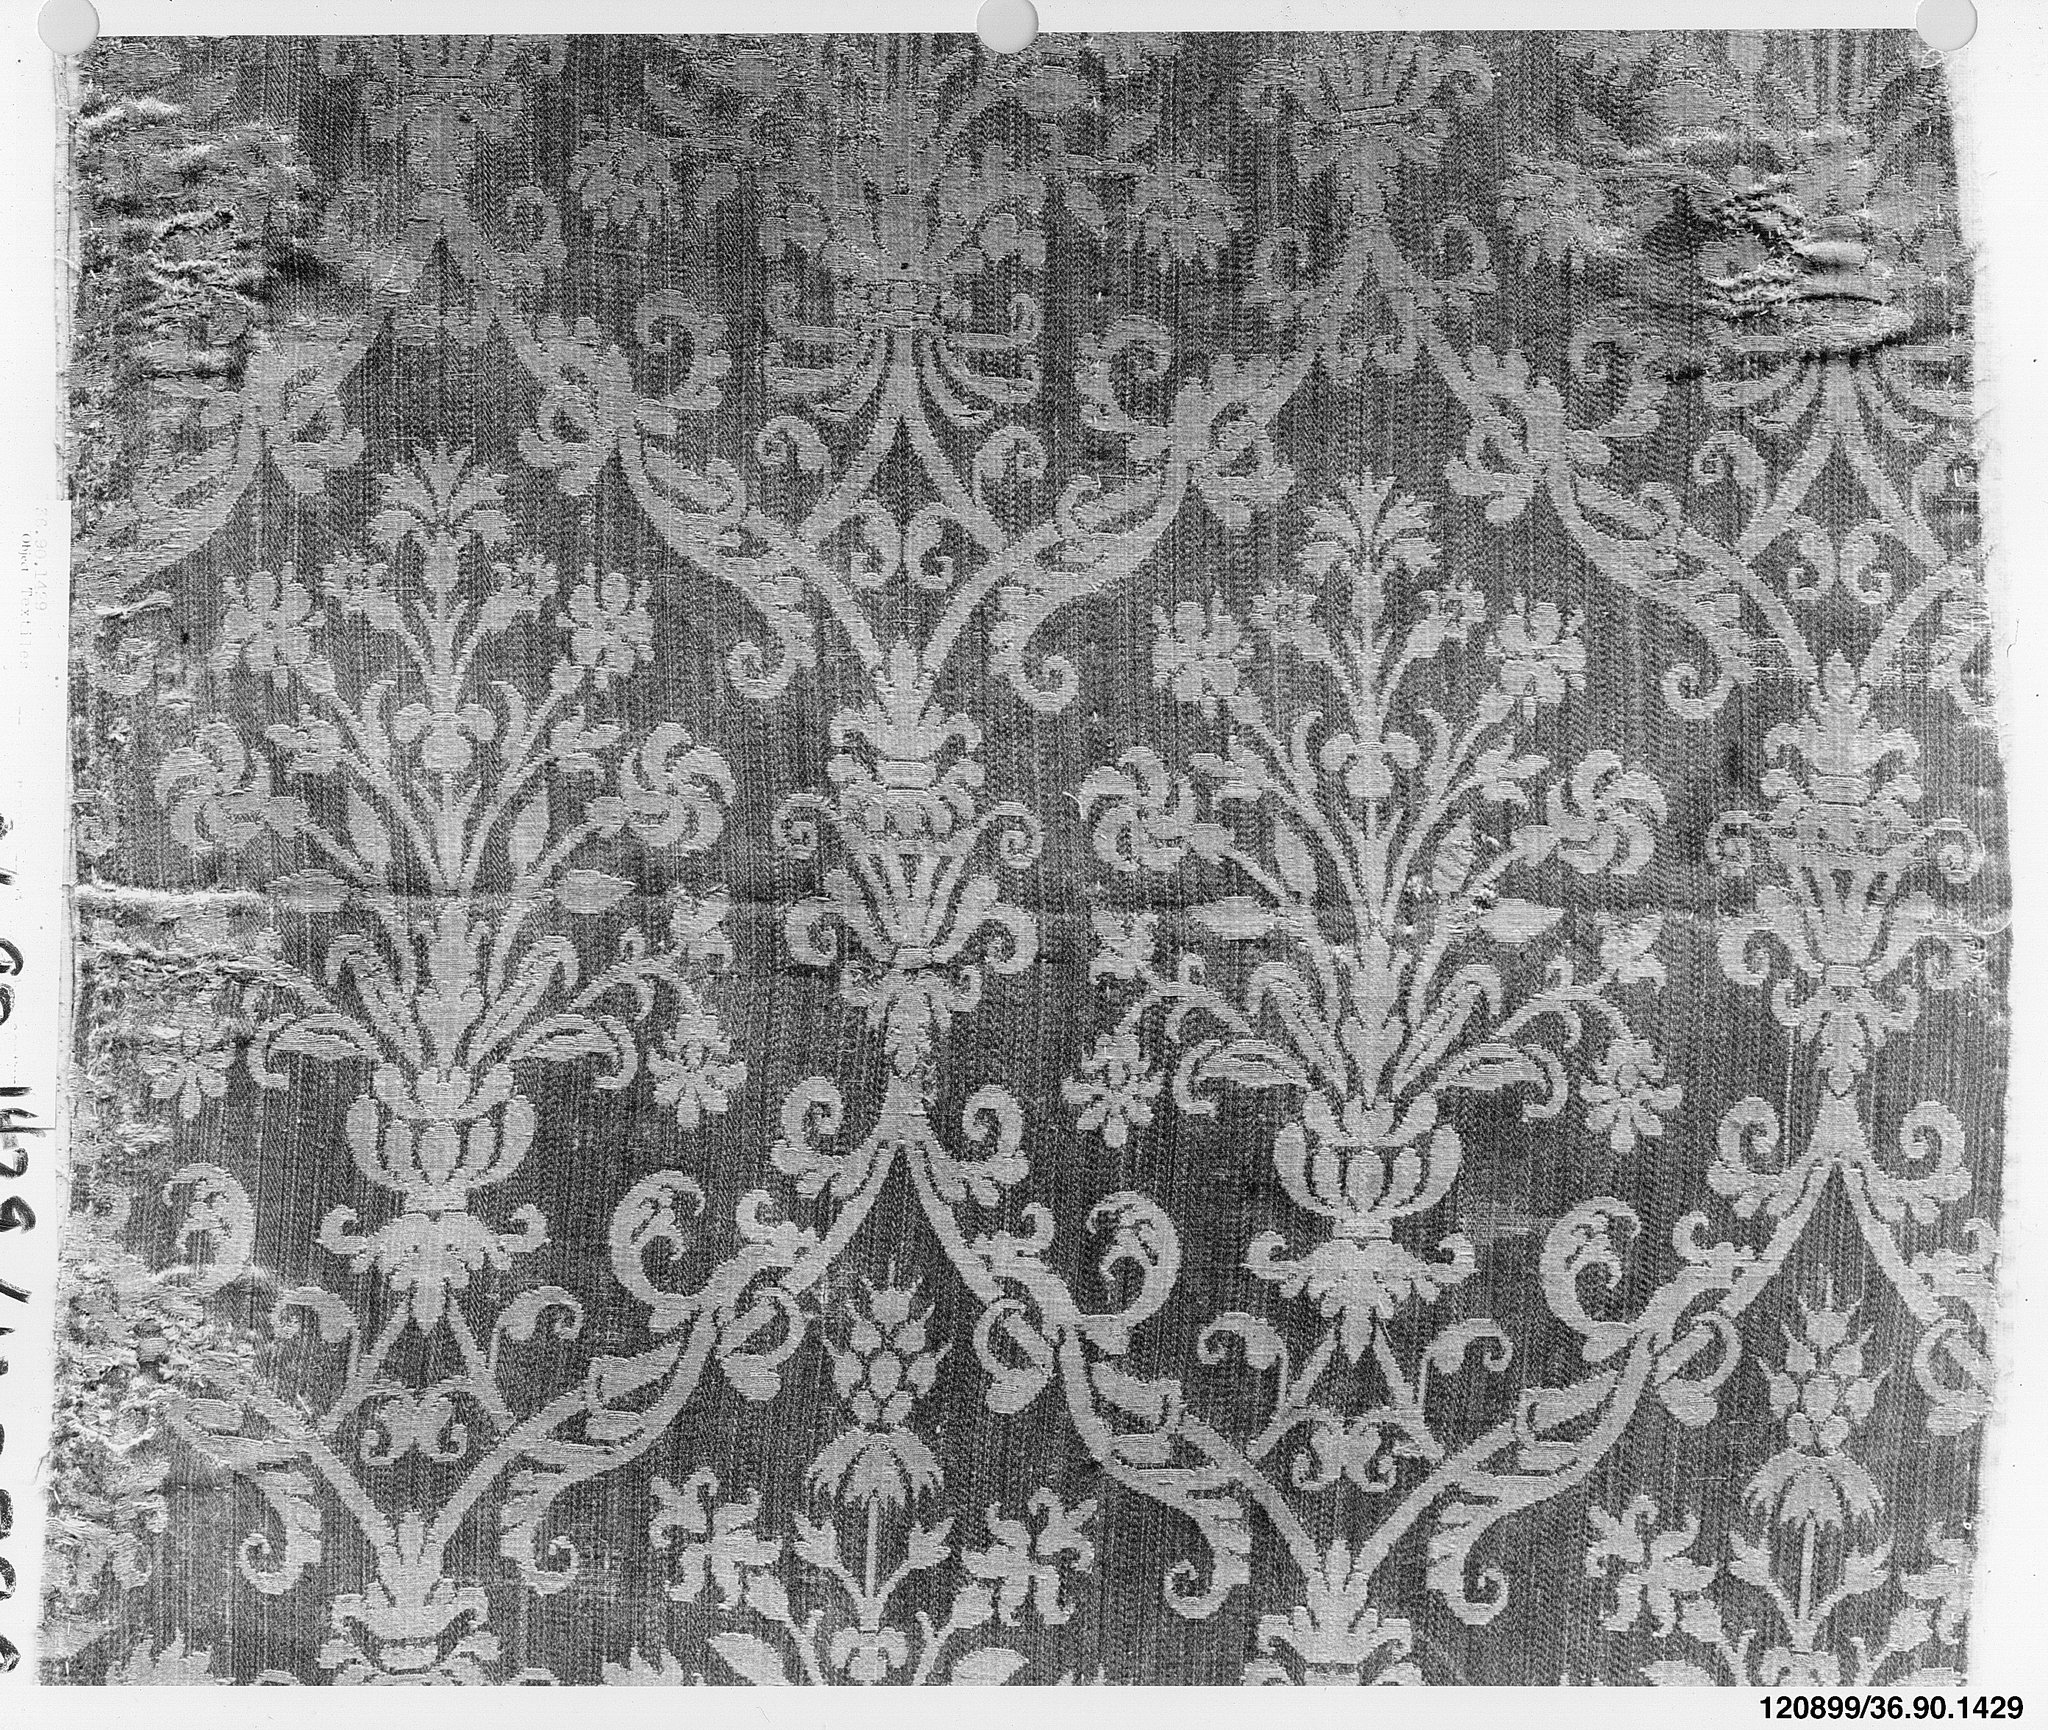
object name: piece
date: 1601-1700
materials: silk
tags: flowers,leaves